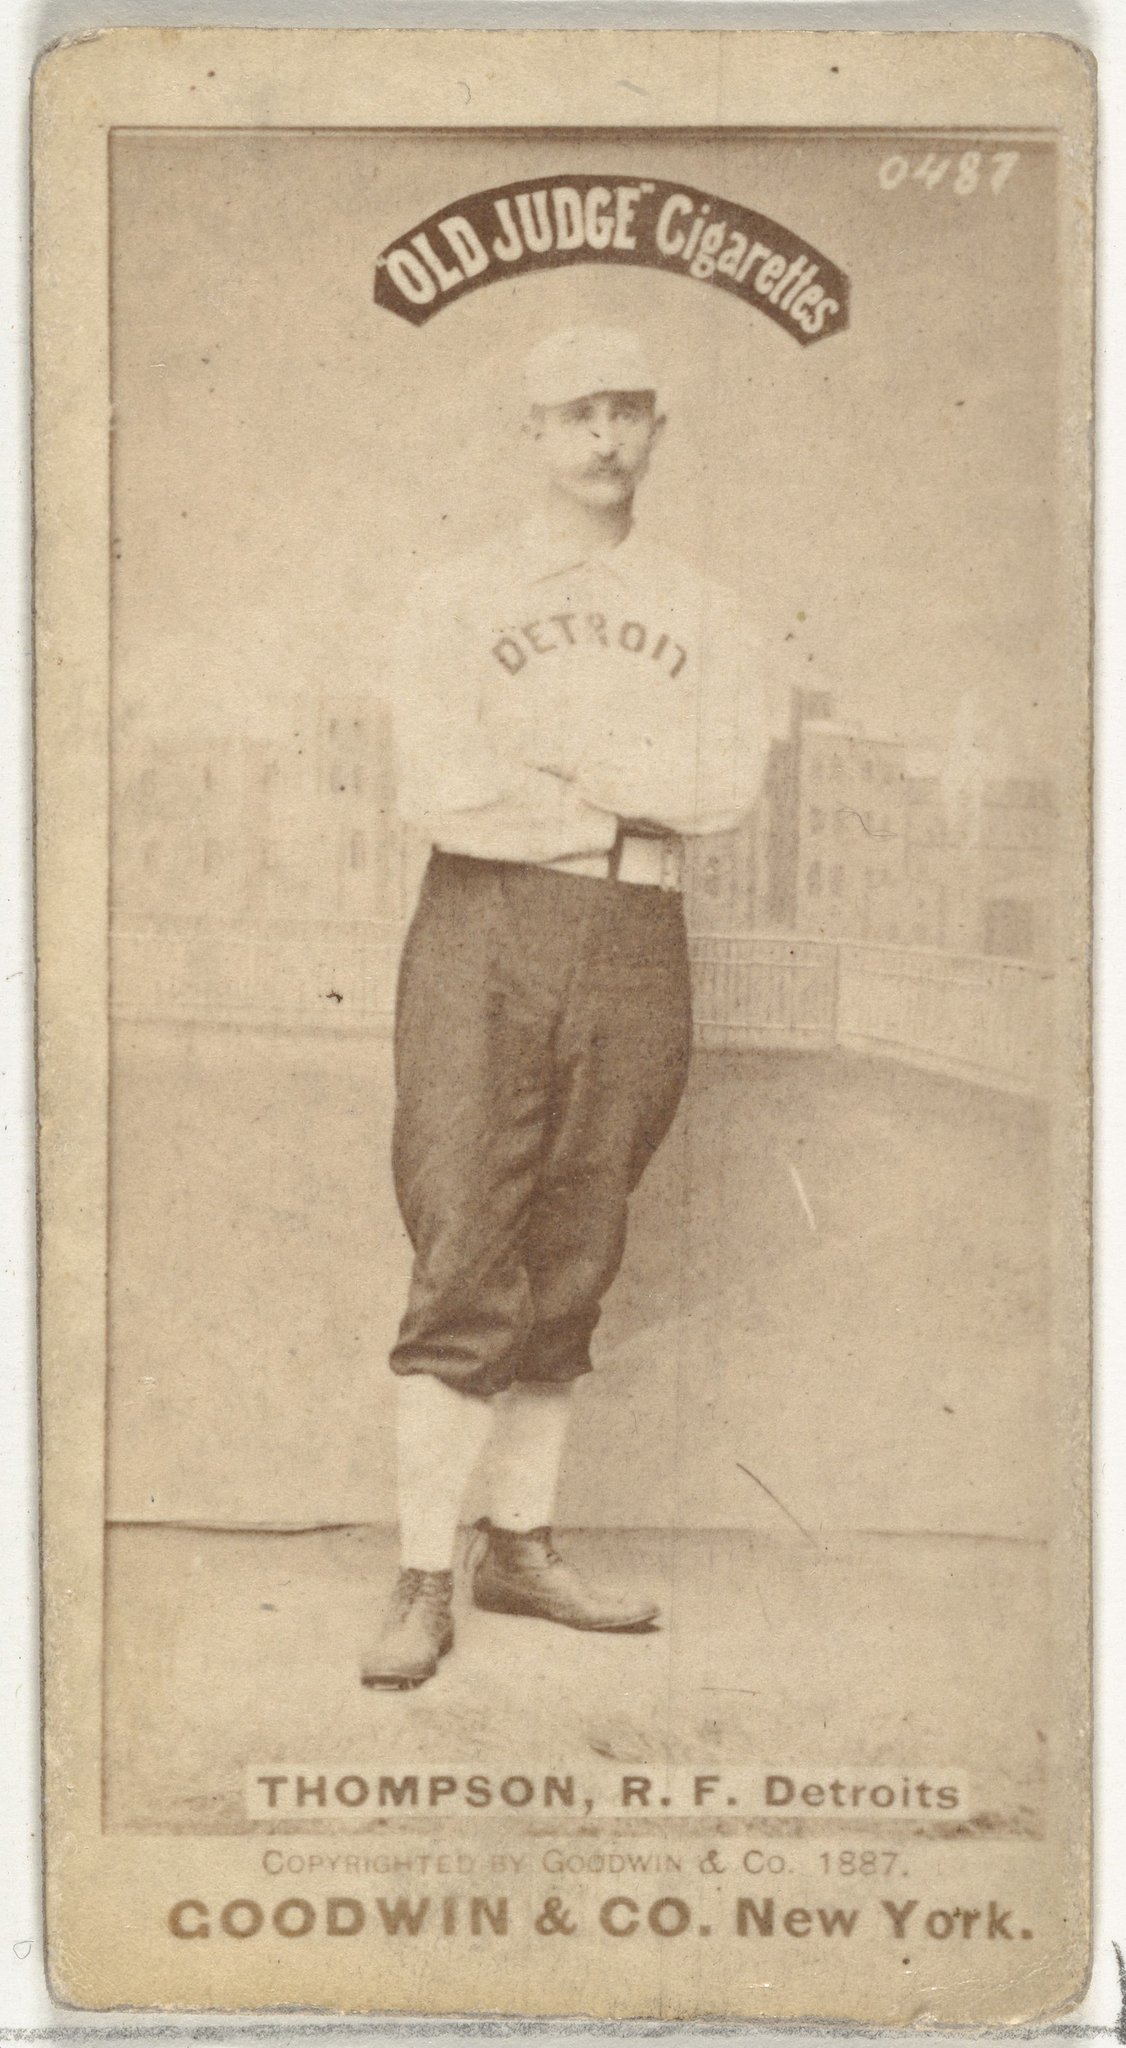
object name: baseball card, photograph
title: Samuel Luther "Sam" Thompson, Right Field, Detroit Wolverines, from the Old Judge series (N172) for Old Judge Cigarettes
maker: goodwin & company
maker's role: publisher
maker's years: 1850-1950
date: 1887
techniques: albumen silver print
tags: men,portraits,baseball,athletes